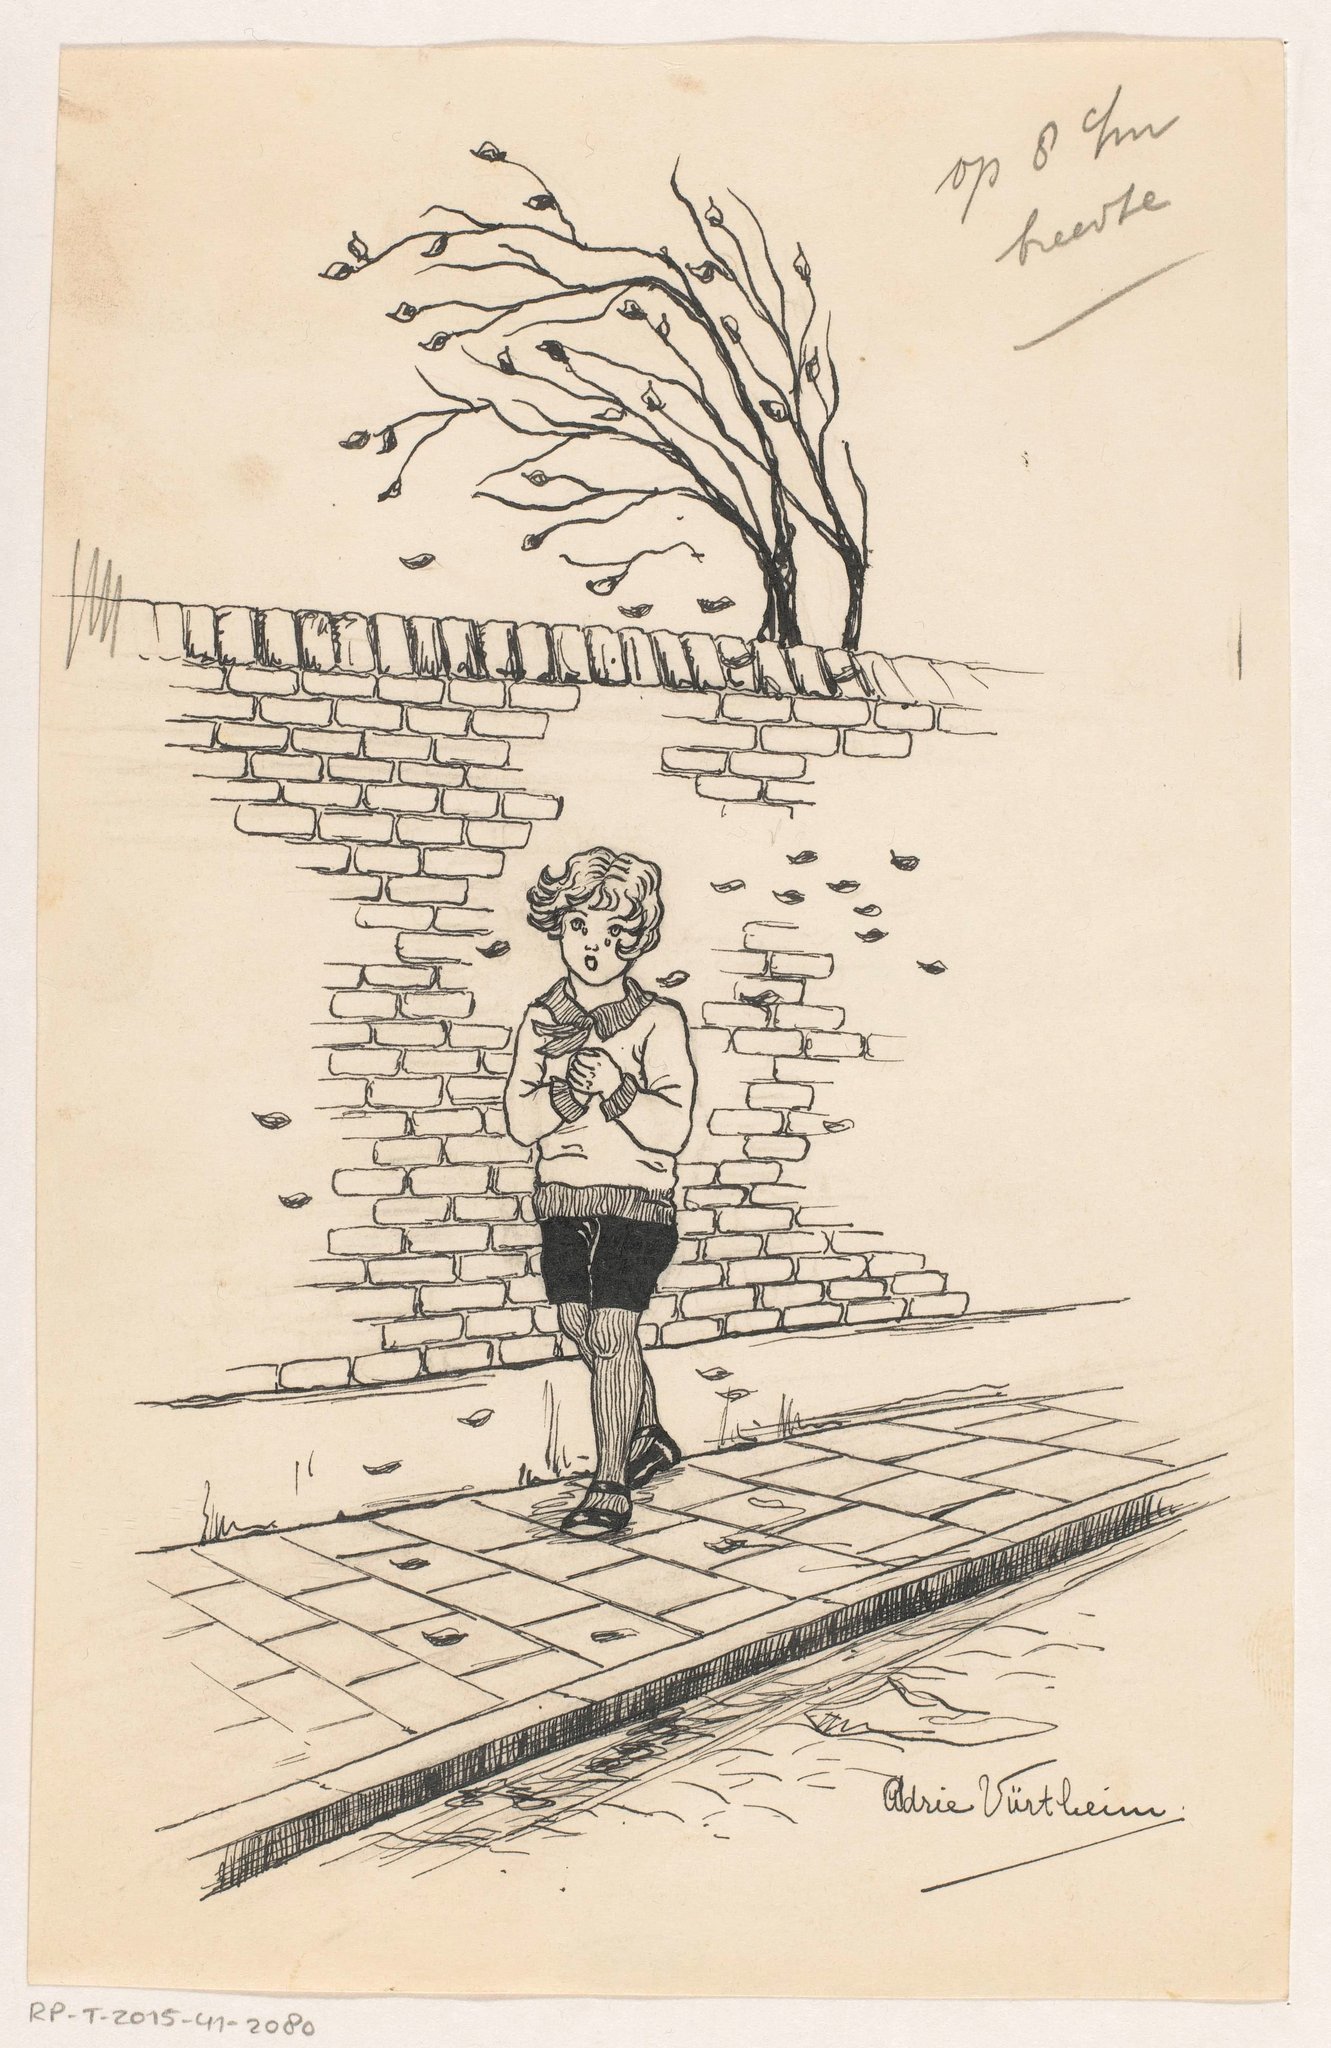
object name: drawing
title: Huilend meisje op straat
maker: adrie vürtheim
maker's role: draughtsman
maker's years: 1907-1995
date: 1917-1970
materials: ink, paper, pencil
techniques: pen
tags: tears, winds, street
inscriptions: :, collector's mark: Lugt 2228a, signature: ‘Adrie Vürtheim.’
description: Een meisje loopt zonder jas en met een betraand gezicht over straat in de herfstwind. Ze houdt haar handen tegen elkaar geklemd. Achter haar verliest een boom zijn bladeren.